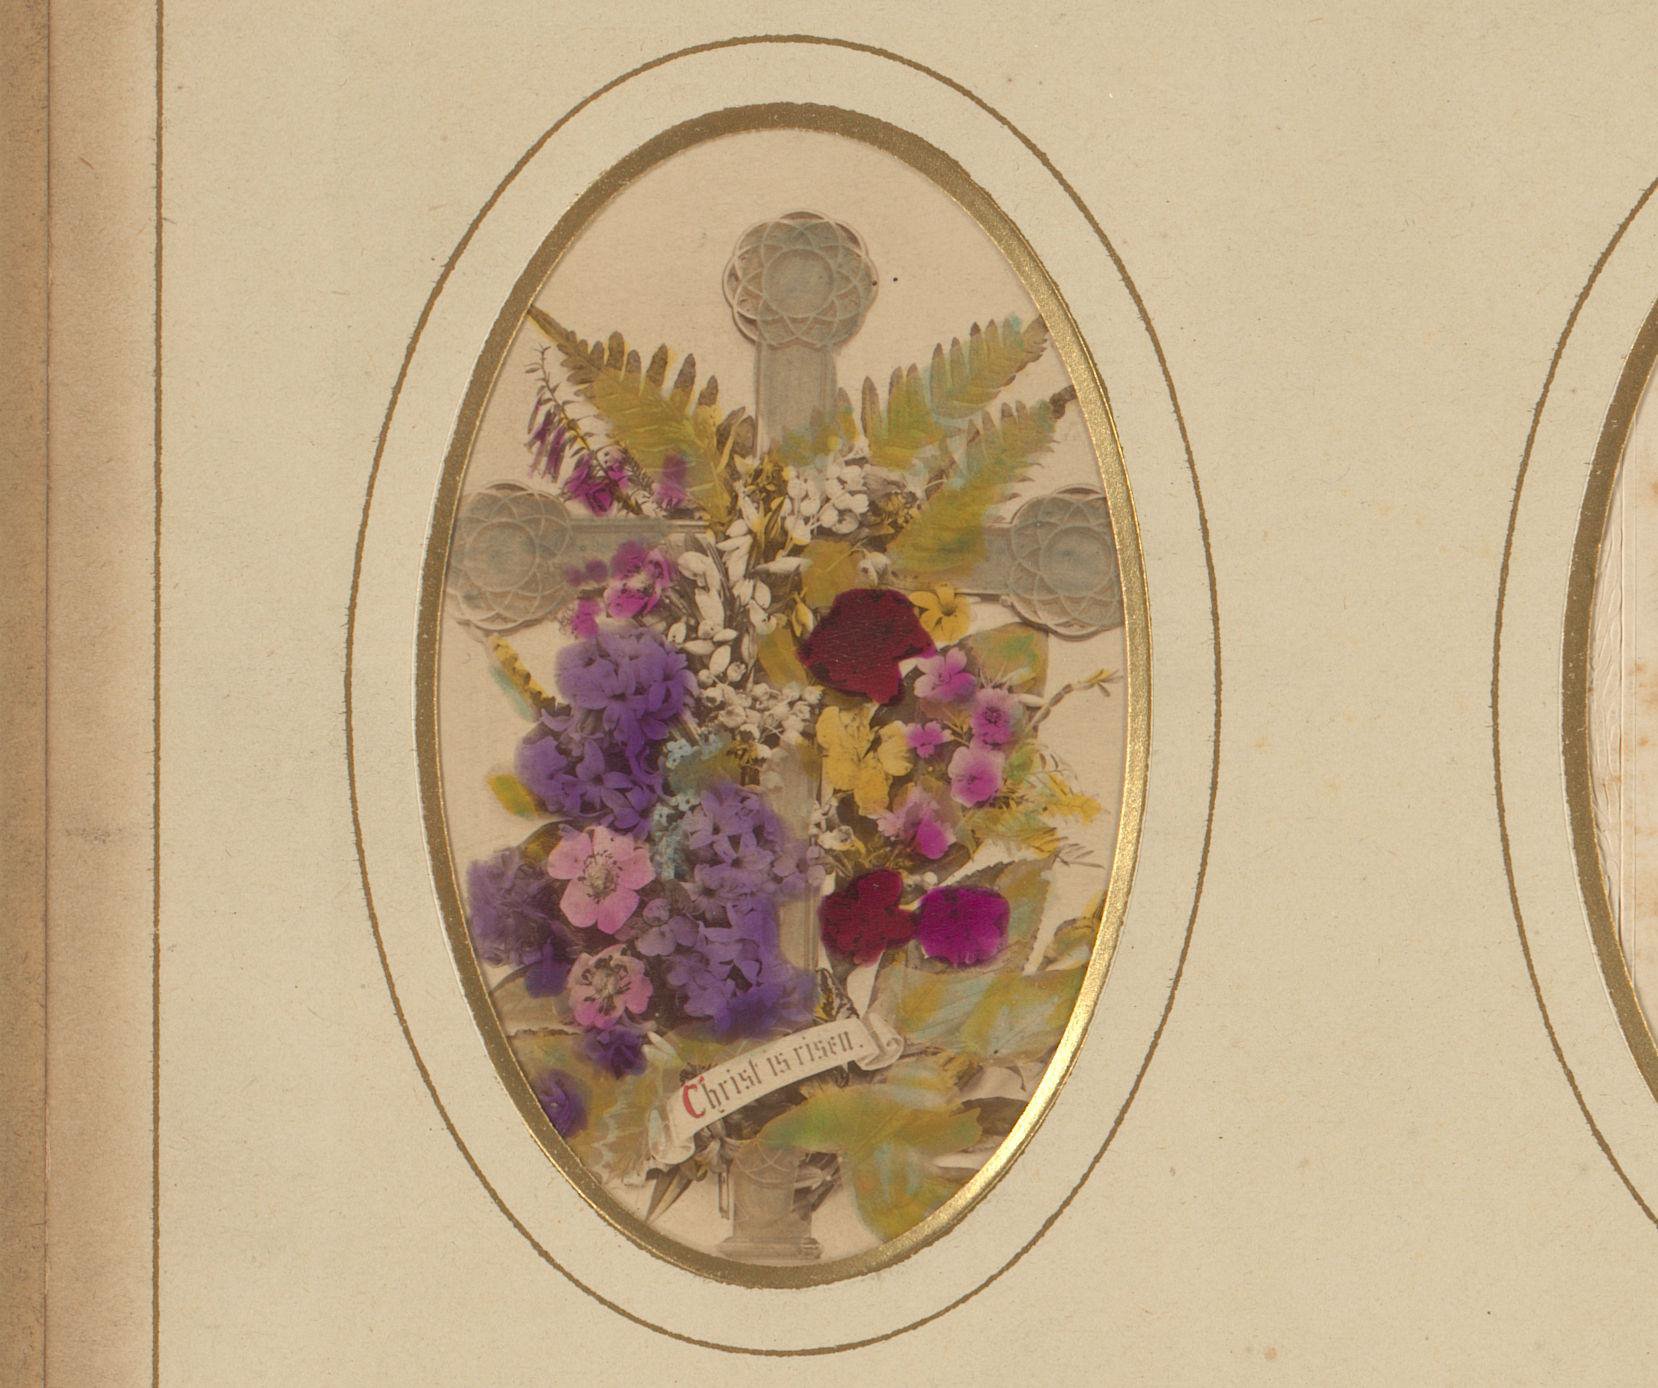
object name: photograph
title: Kruis met bloemen en een lint met de tekst 'Christ has risen'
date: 1860-1900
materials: cardboard, photographic support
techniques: albumen print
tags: flowers, cross as symbol of christ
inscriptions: inscription: ‘William Luks/ London’, inscription: ‘W.L. copyright London’